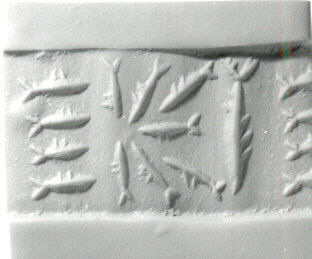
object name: cylinder seal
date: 3667-2334 BCE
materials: stone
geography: syria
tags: fish